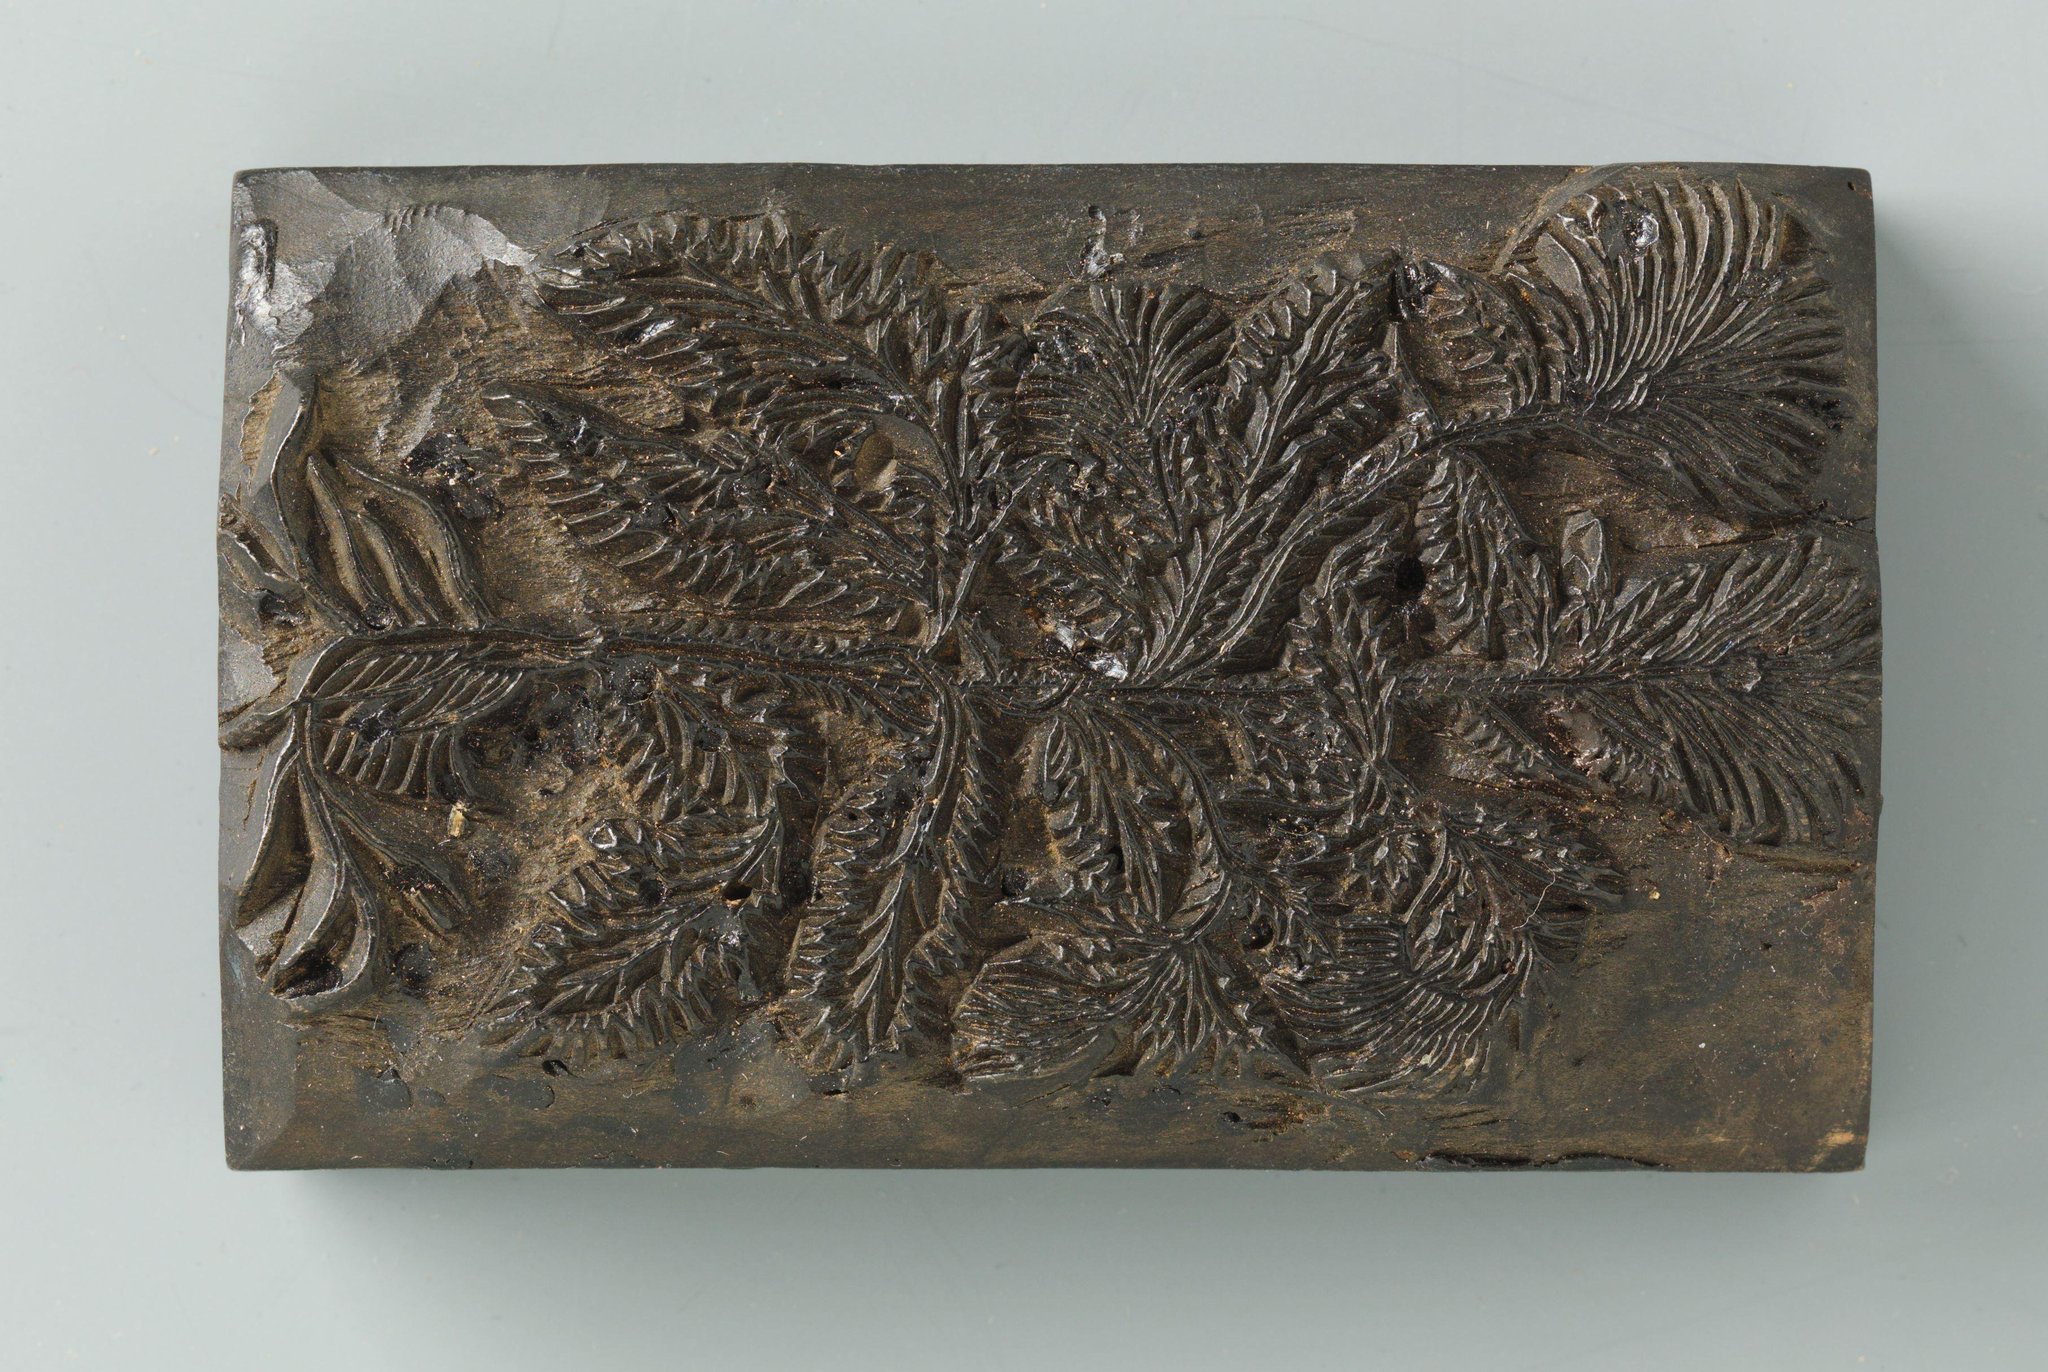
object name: wood block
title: Plant met veel blad en drie bloemen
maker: Anonymous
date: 1600-1699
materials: wood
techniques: woodcut